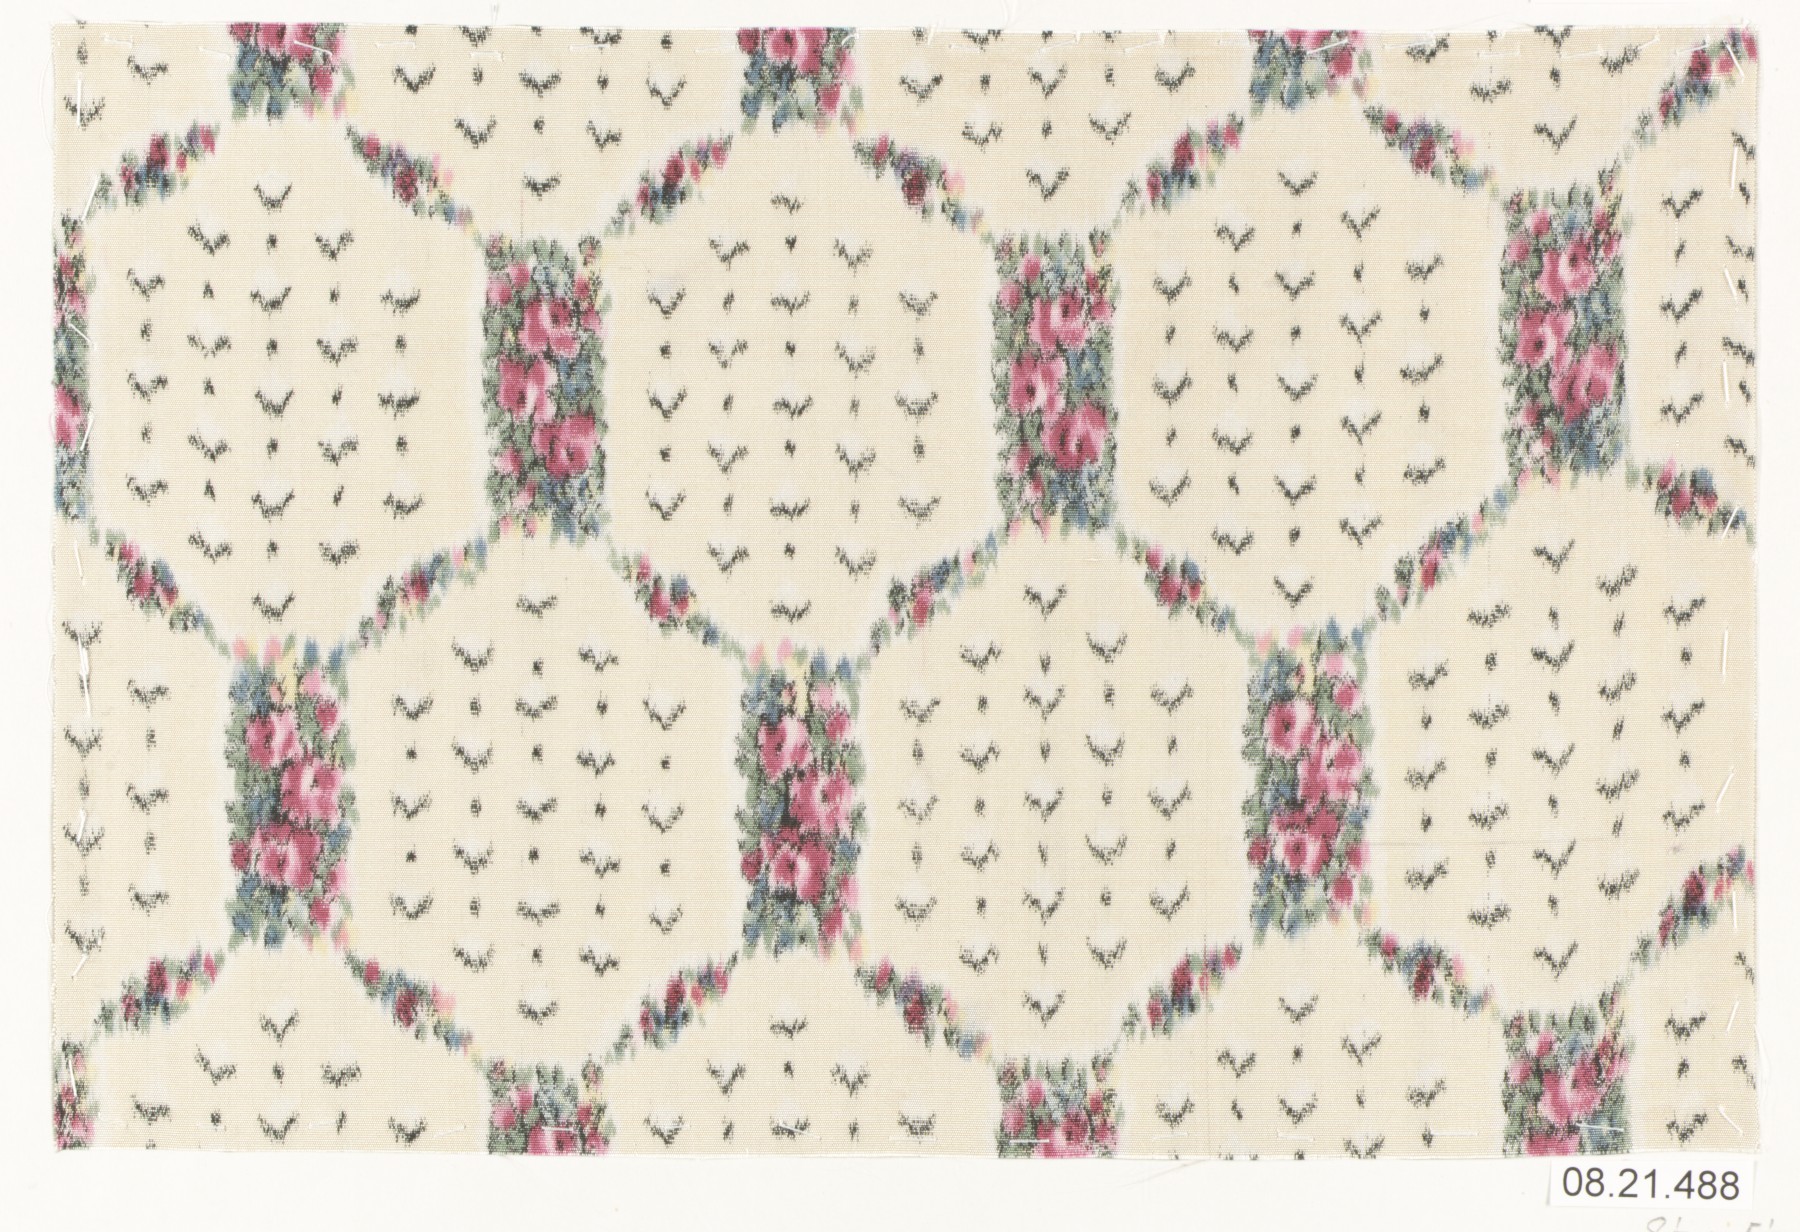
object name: textile sample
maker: Anonymous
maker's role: designer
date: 1900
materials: silk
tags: flowers